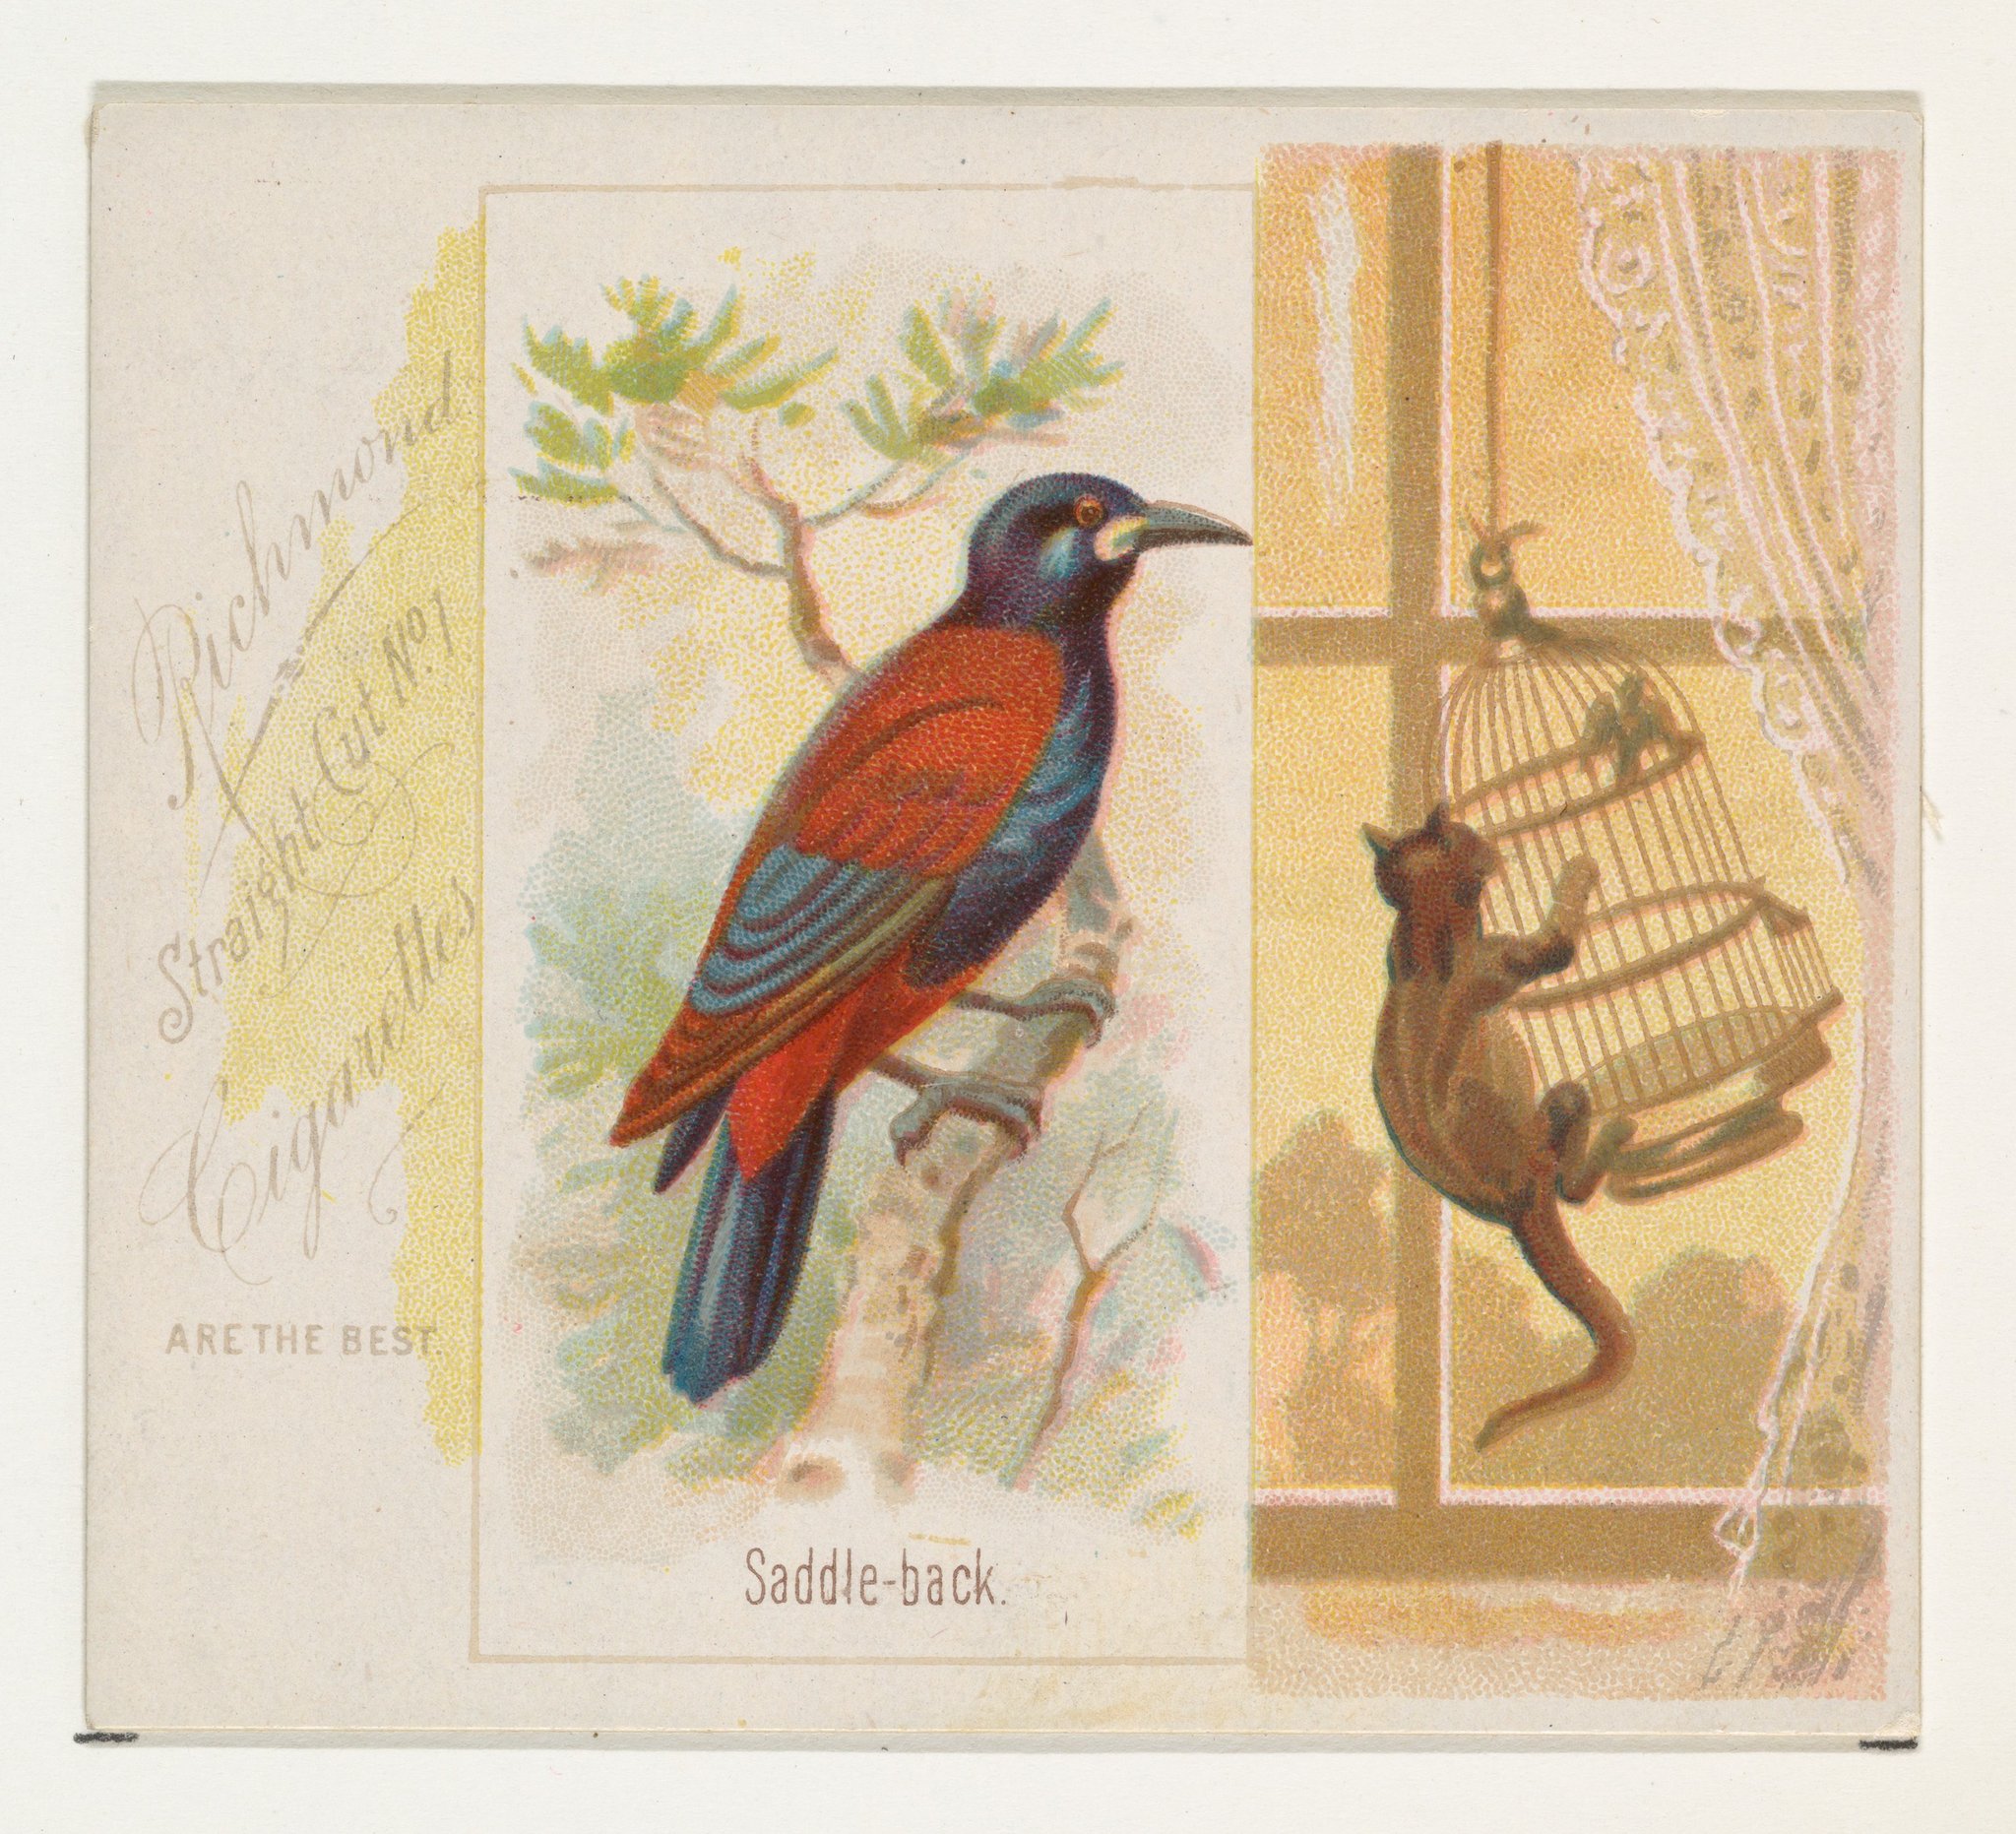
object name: print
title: Saddle-back, from the Song Birds of the World series (N42) for Allen & Ginter Cigarettes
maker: allen & ginter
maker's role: publisher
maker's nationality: american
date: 1890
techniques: color lithograph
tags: birds,cats